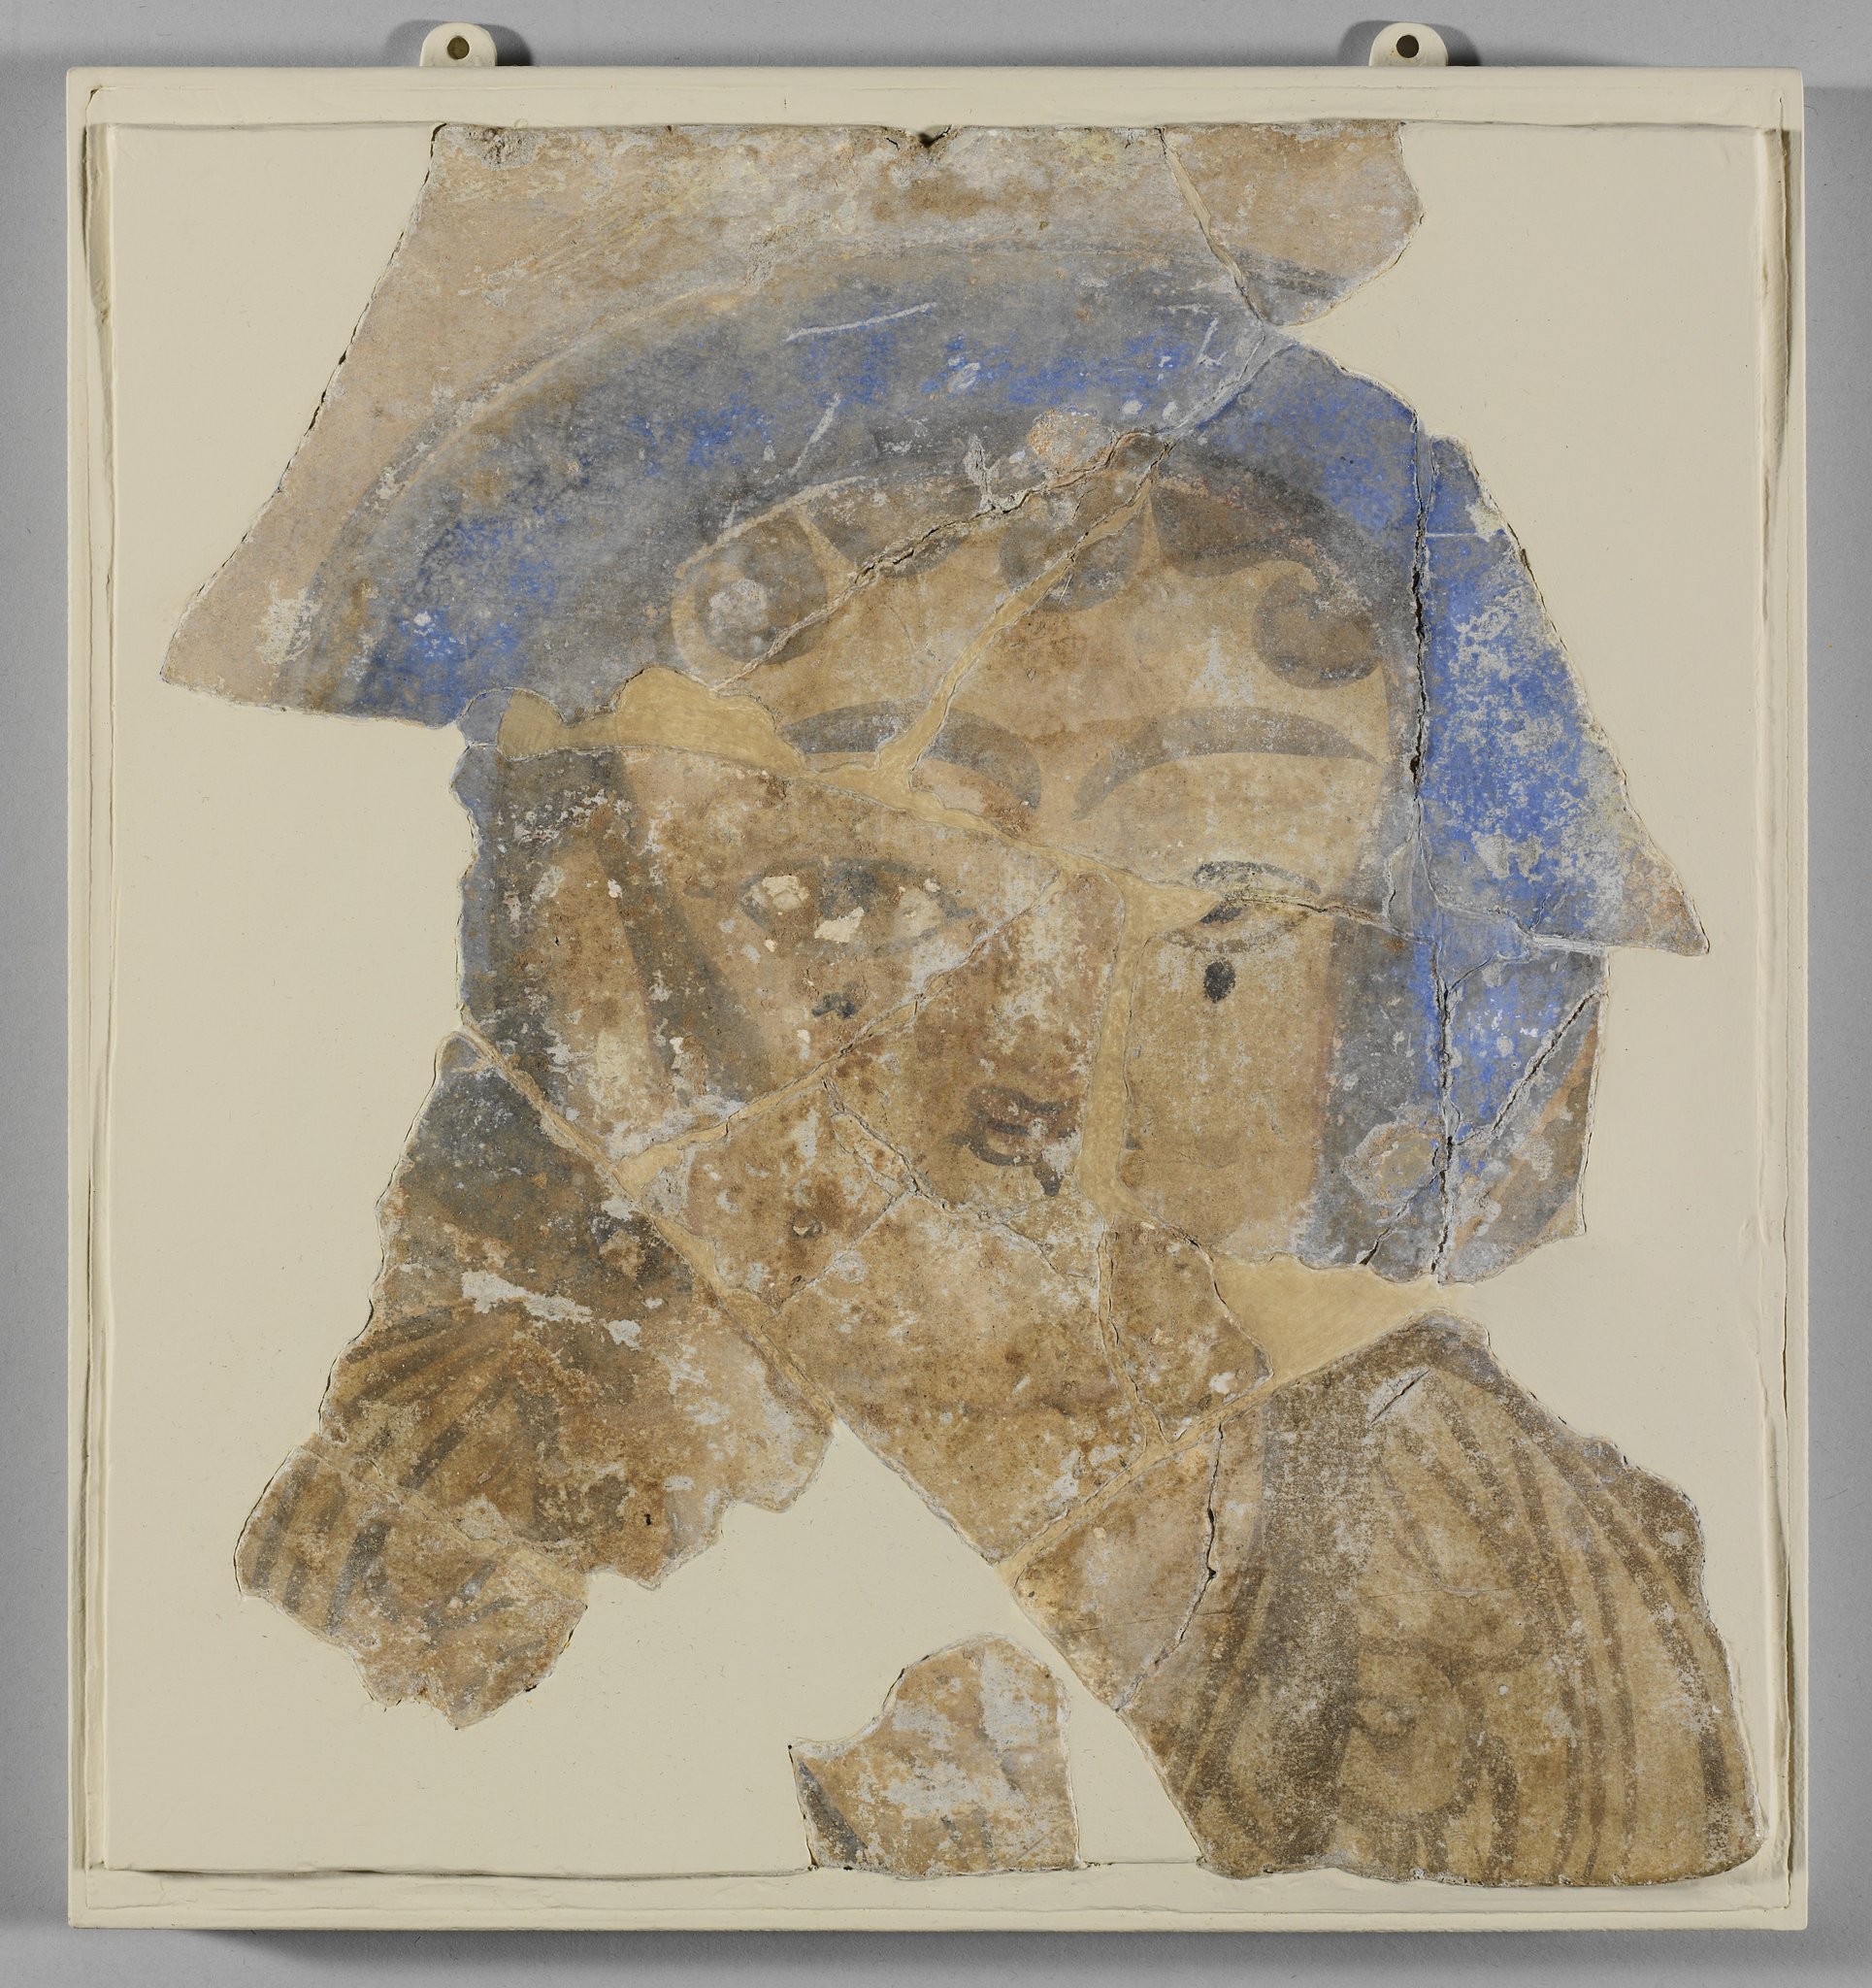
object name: wall painting fragment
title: Wall Painting with Female Figure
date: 801-1000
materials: plaster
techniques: painting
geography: iran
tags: women